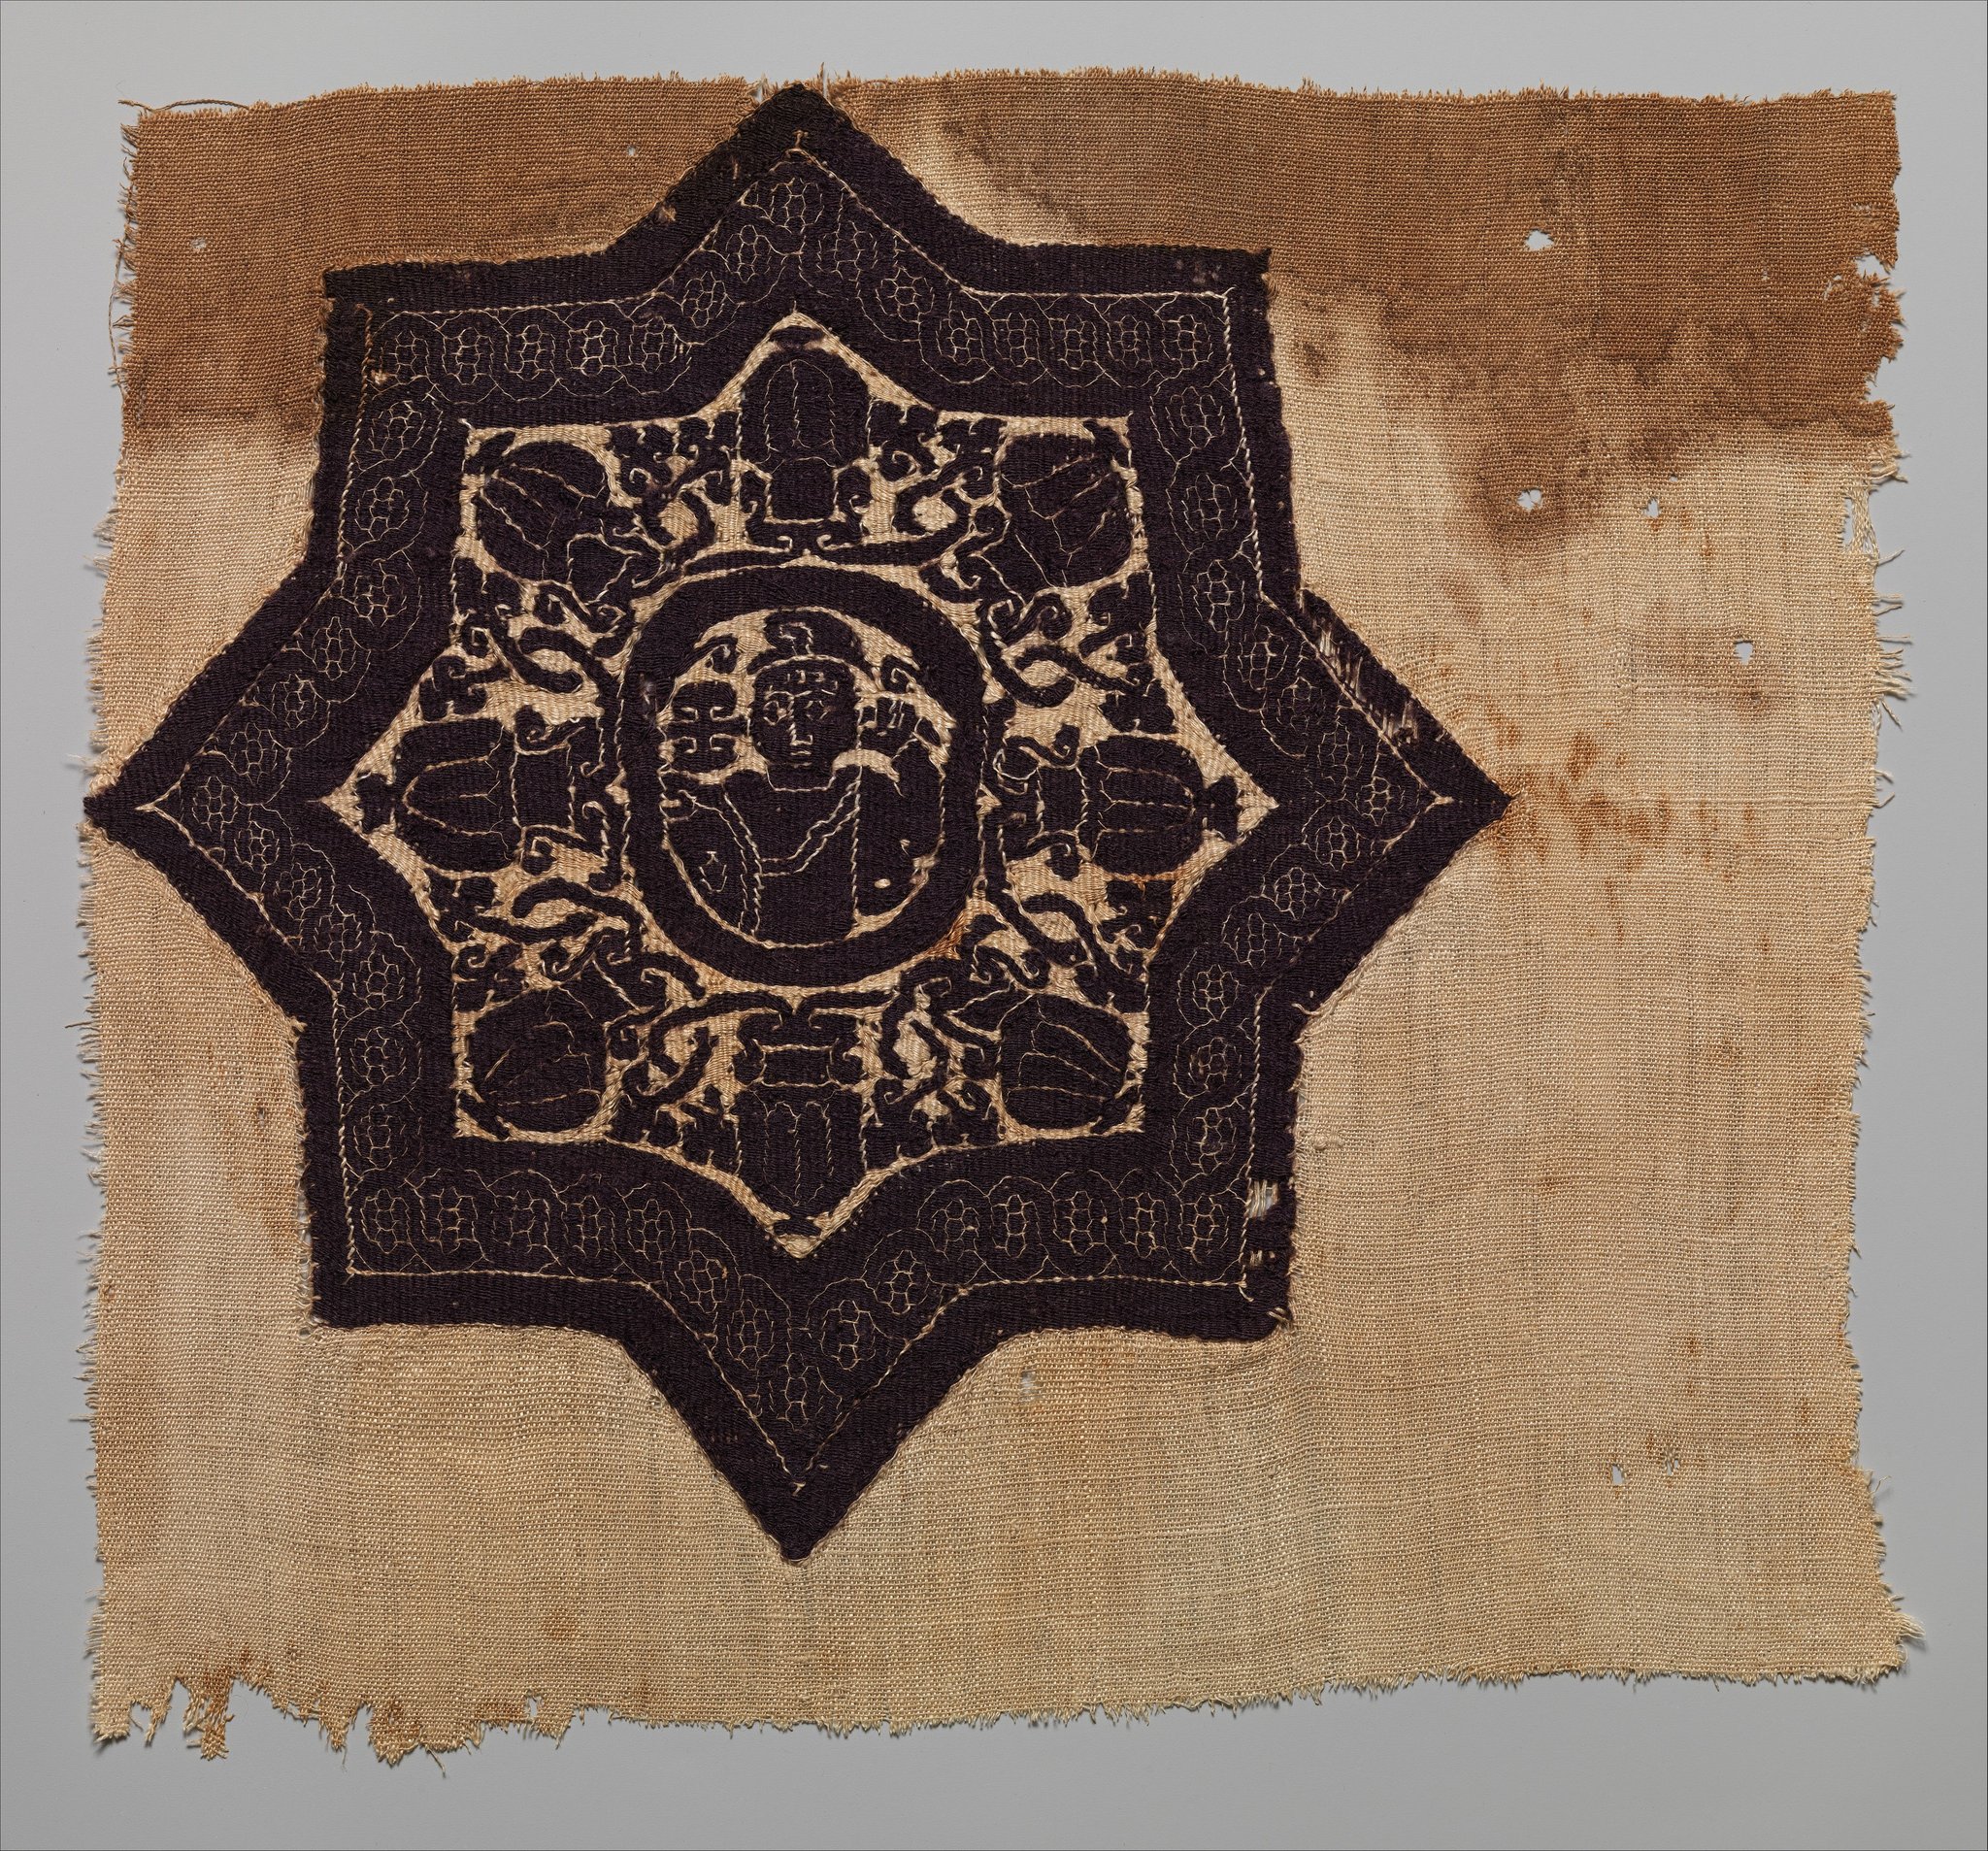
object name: textile fragment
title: Fragment with an Eight-Pointed Star Containing a Warrior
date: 301-600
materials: linen, wool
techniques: weave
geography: egypt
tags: warriors